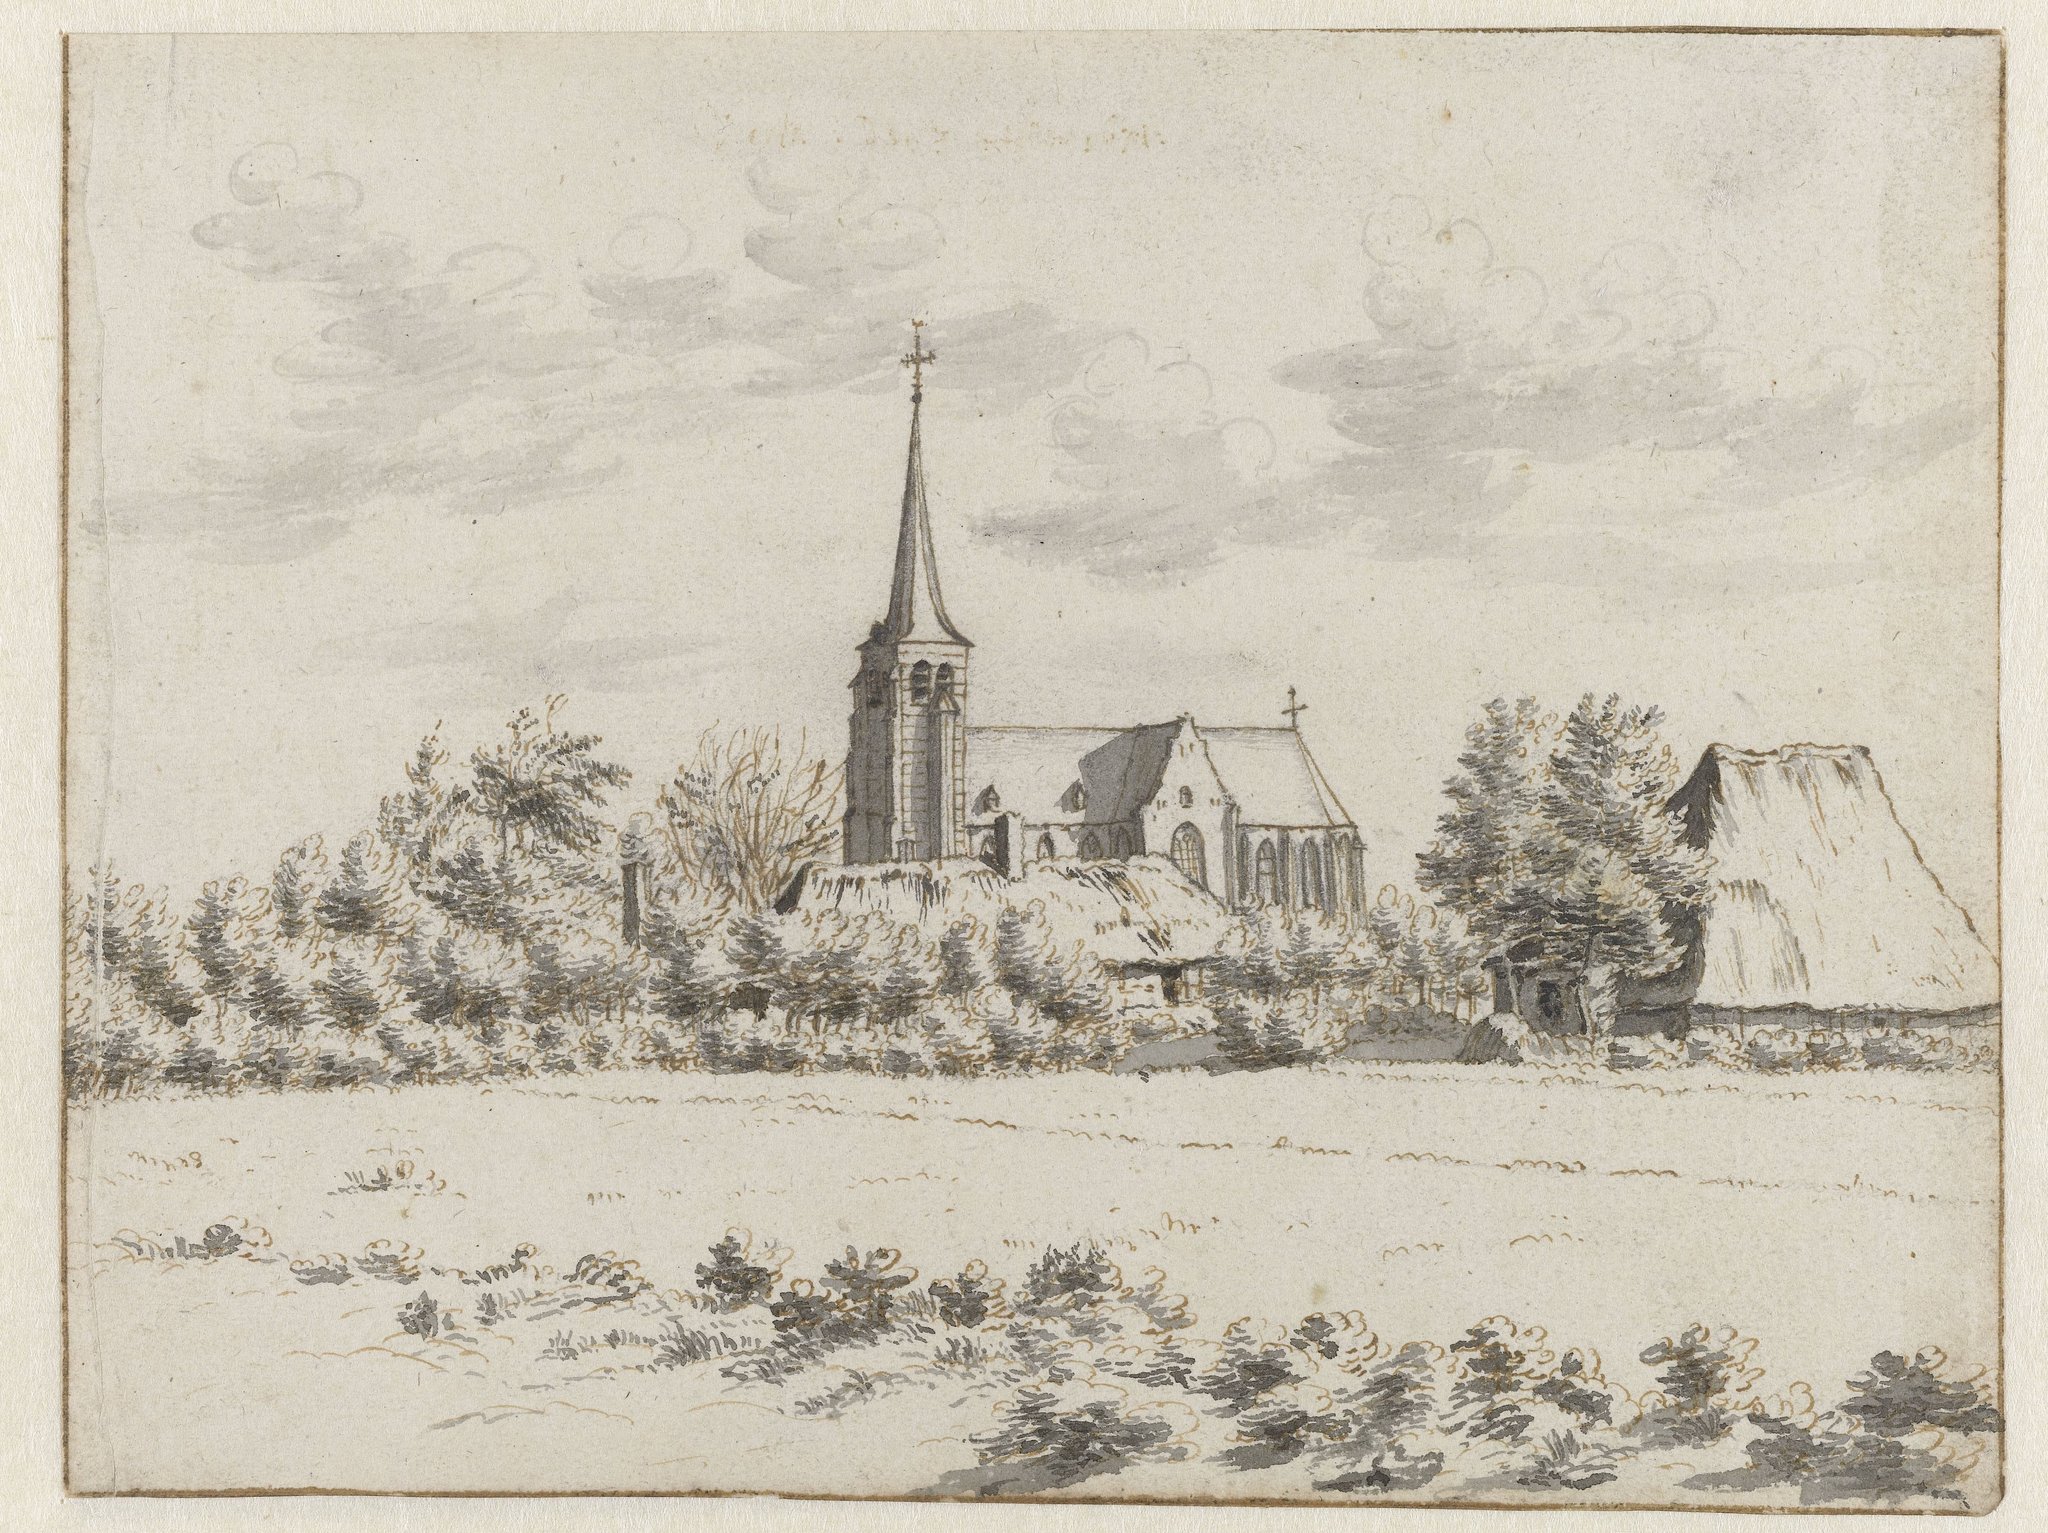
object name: drawing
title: View of the Hamlet of Veerle, near Antwerp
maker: barend klotz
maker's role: draughtsman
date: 1674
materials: ink, paper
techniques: brush, pen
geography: veerle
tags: prospect of village, silhouette of village, church (exterior), veerle